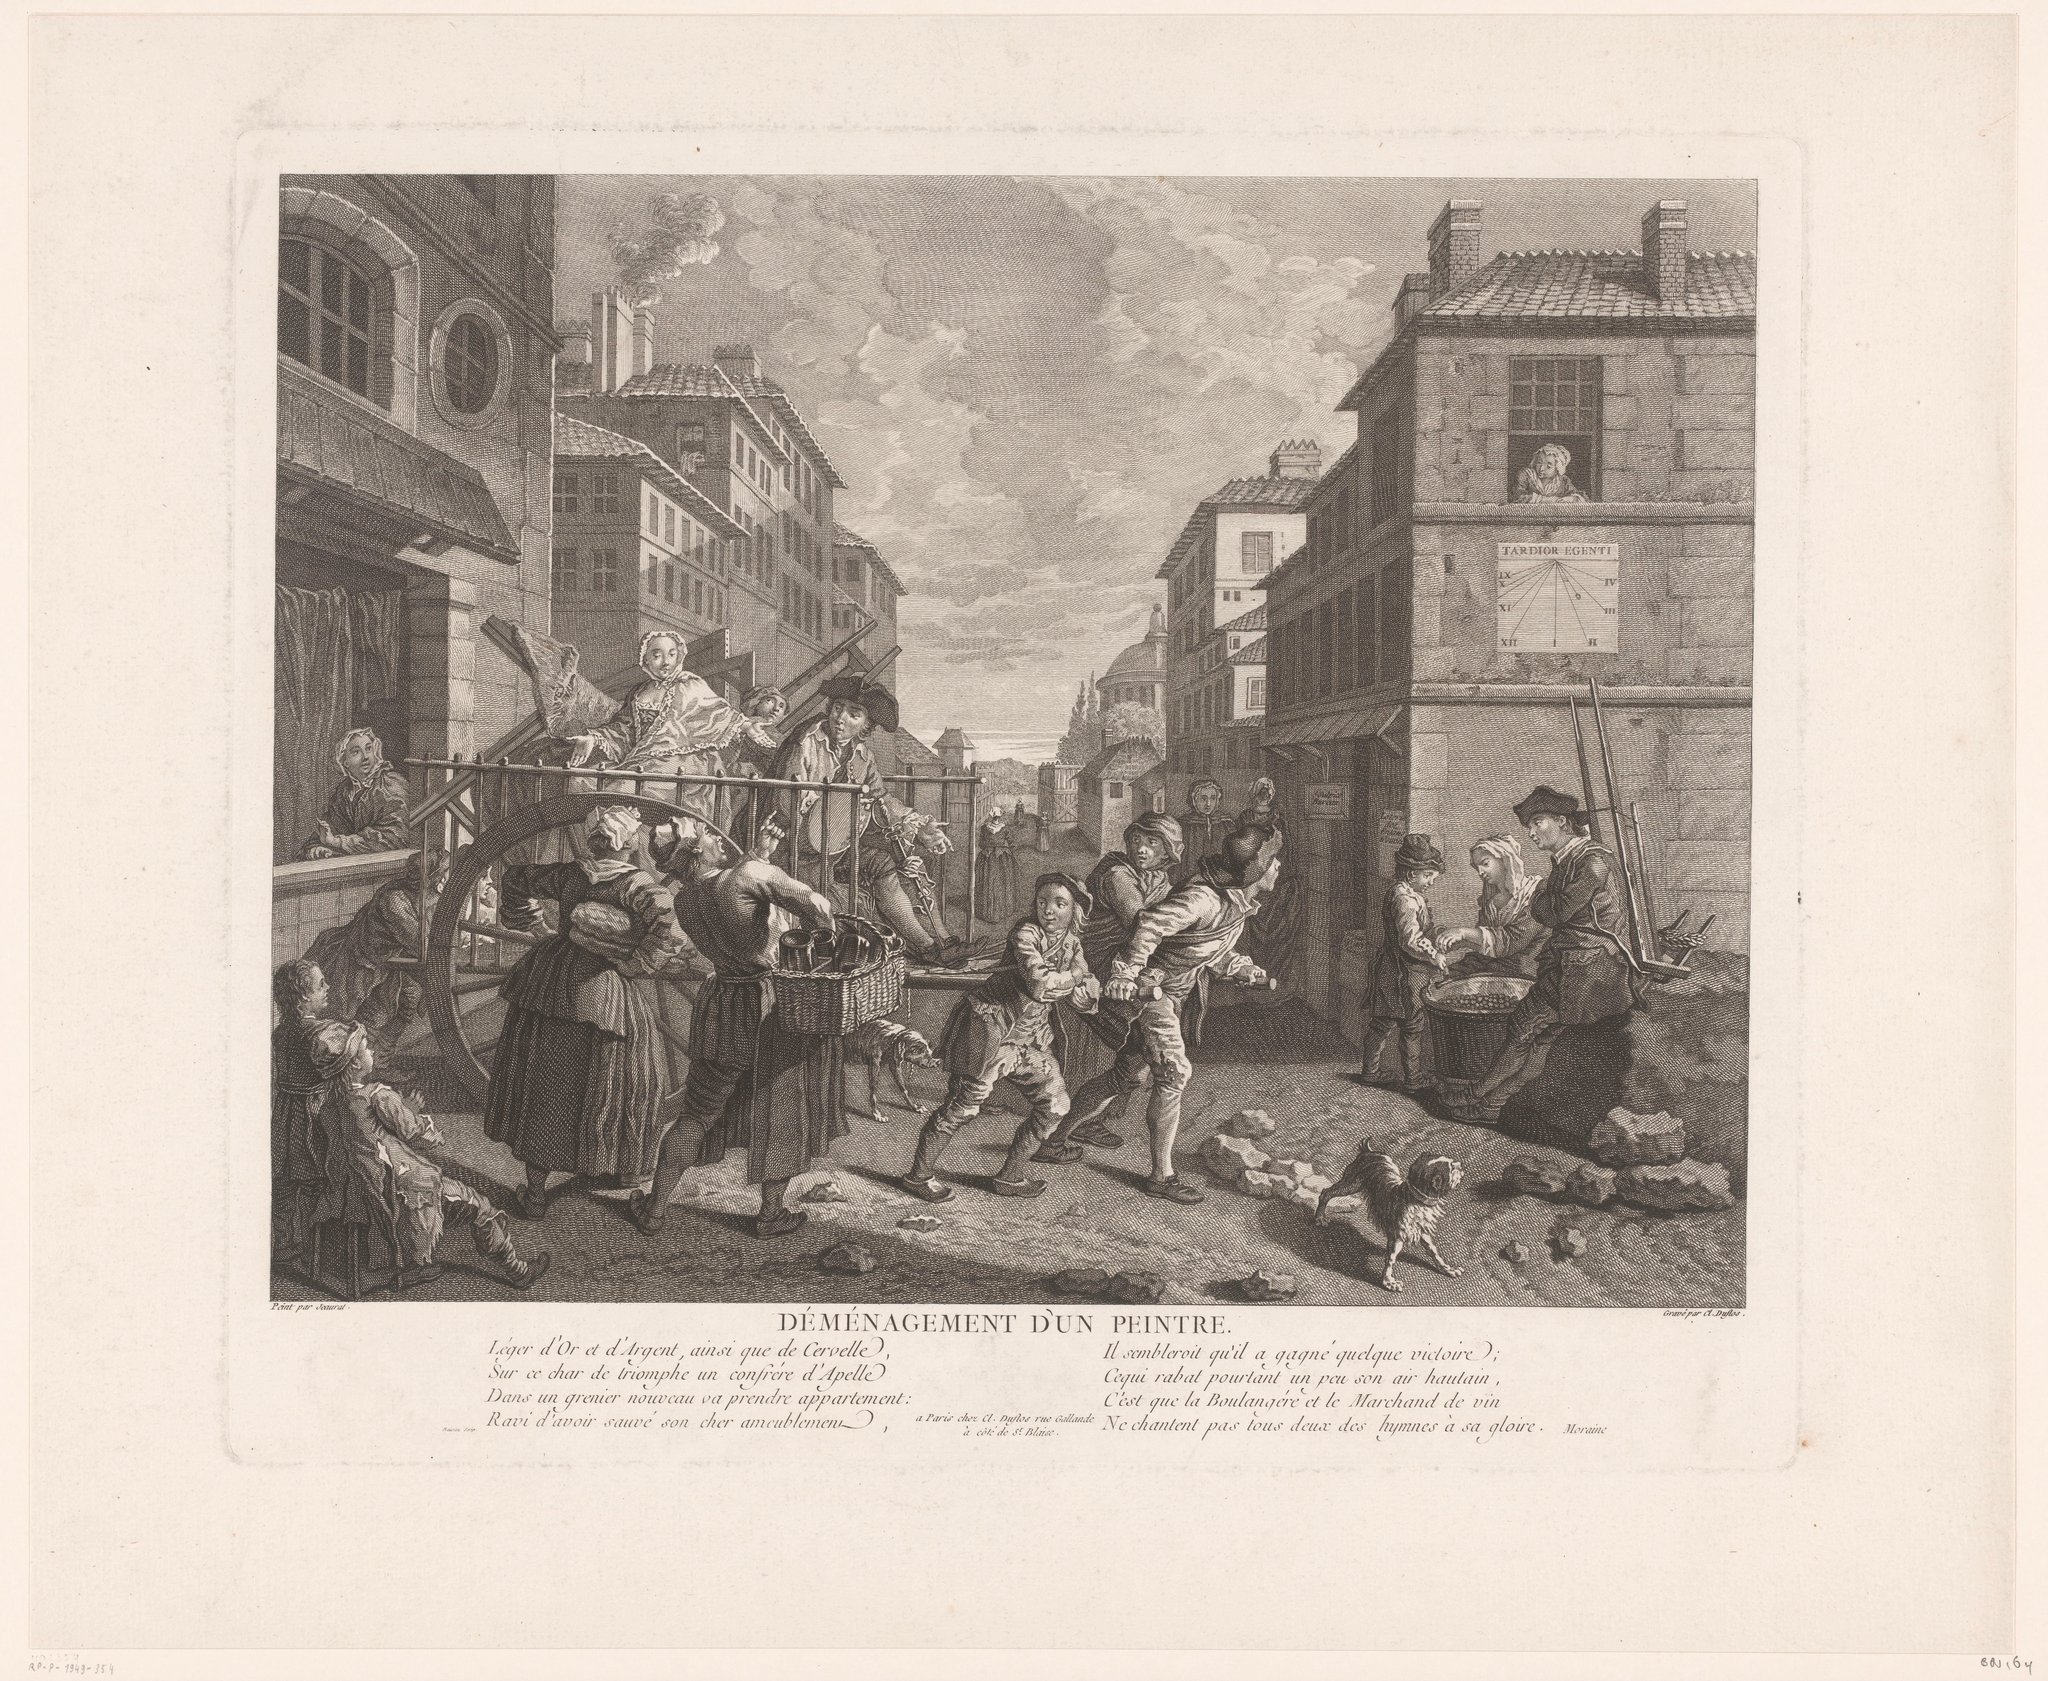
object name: print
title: Déménagement d'un peintre.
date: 1757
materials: paper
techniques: engraving, etching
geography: paris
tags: moving (house), painter in non-work situation, street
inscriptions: collector's mark: Lugt 2228